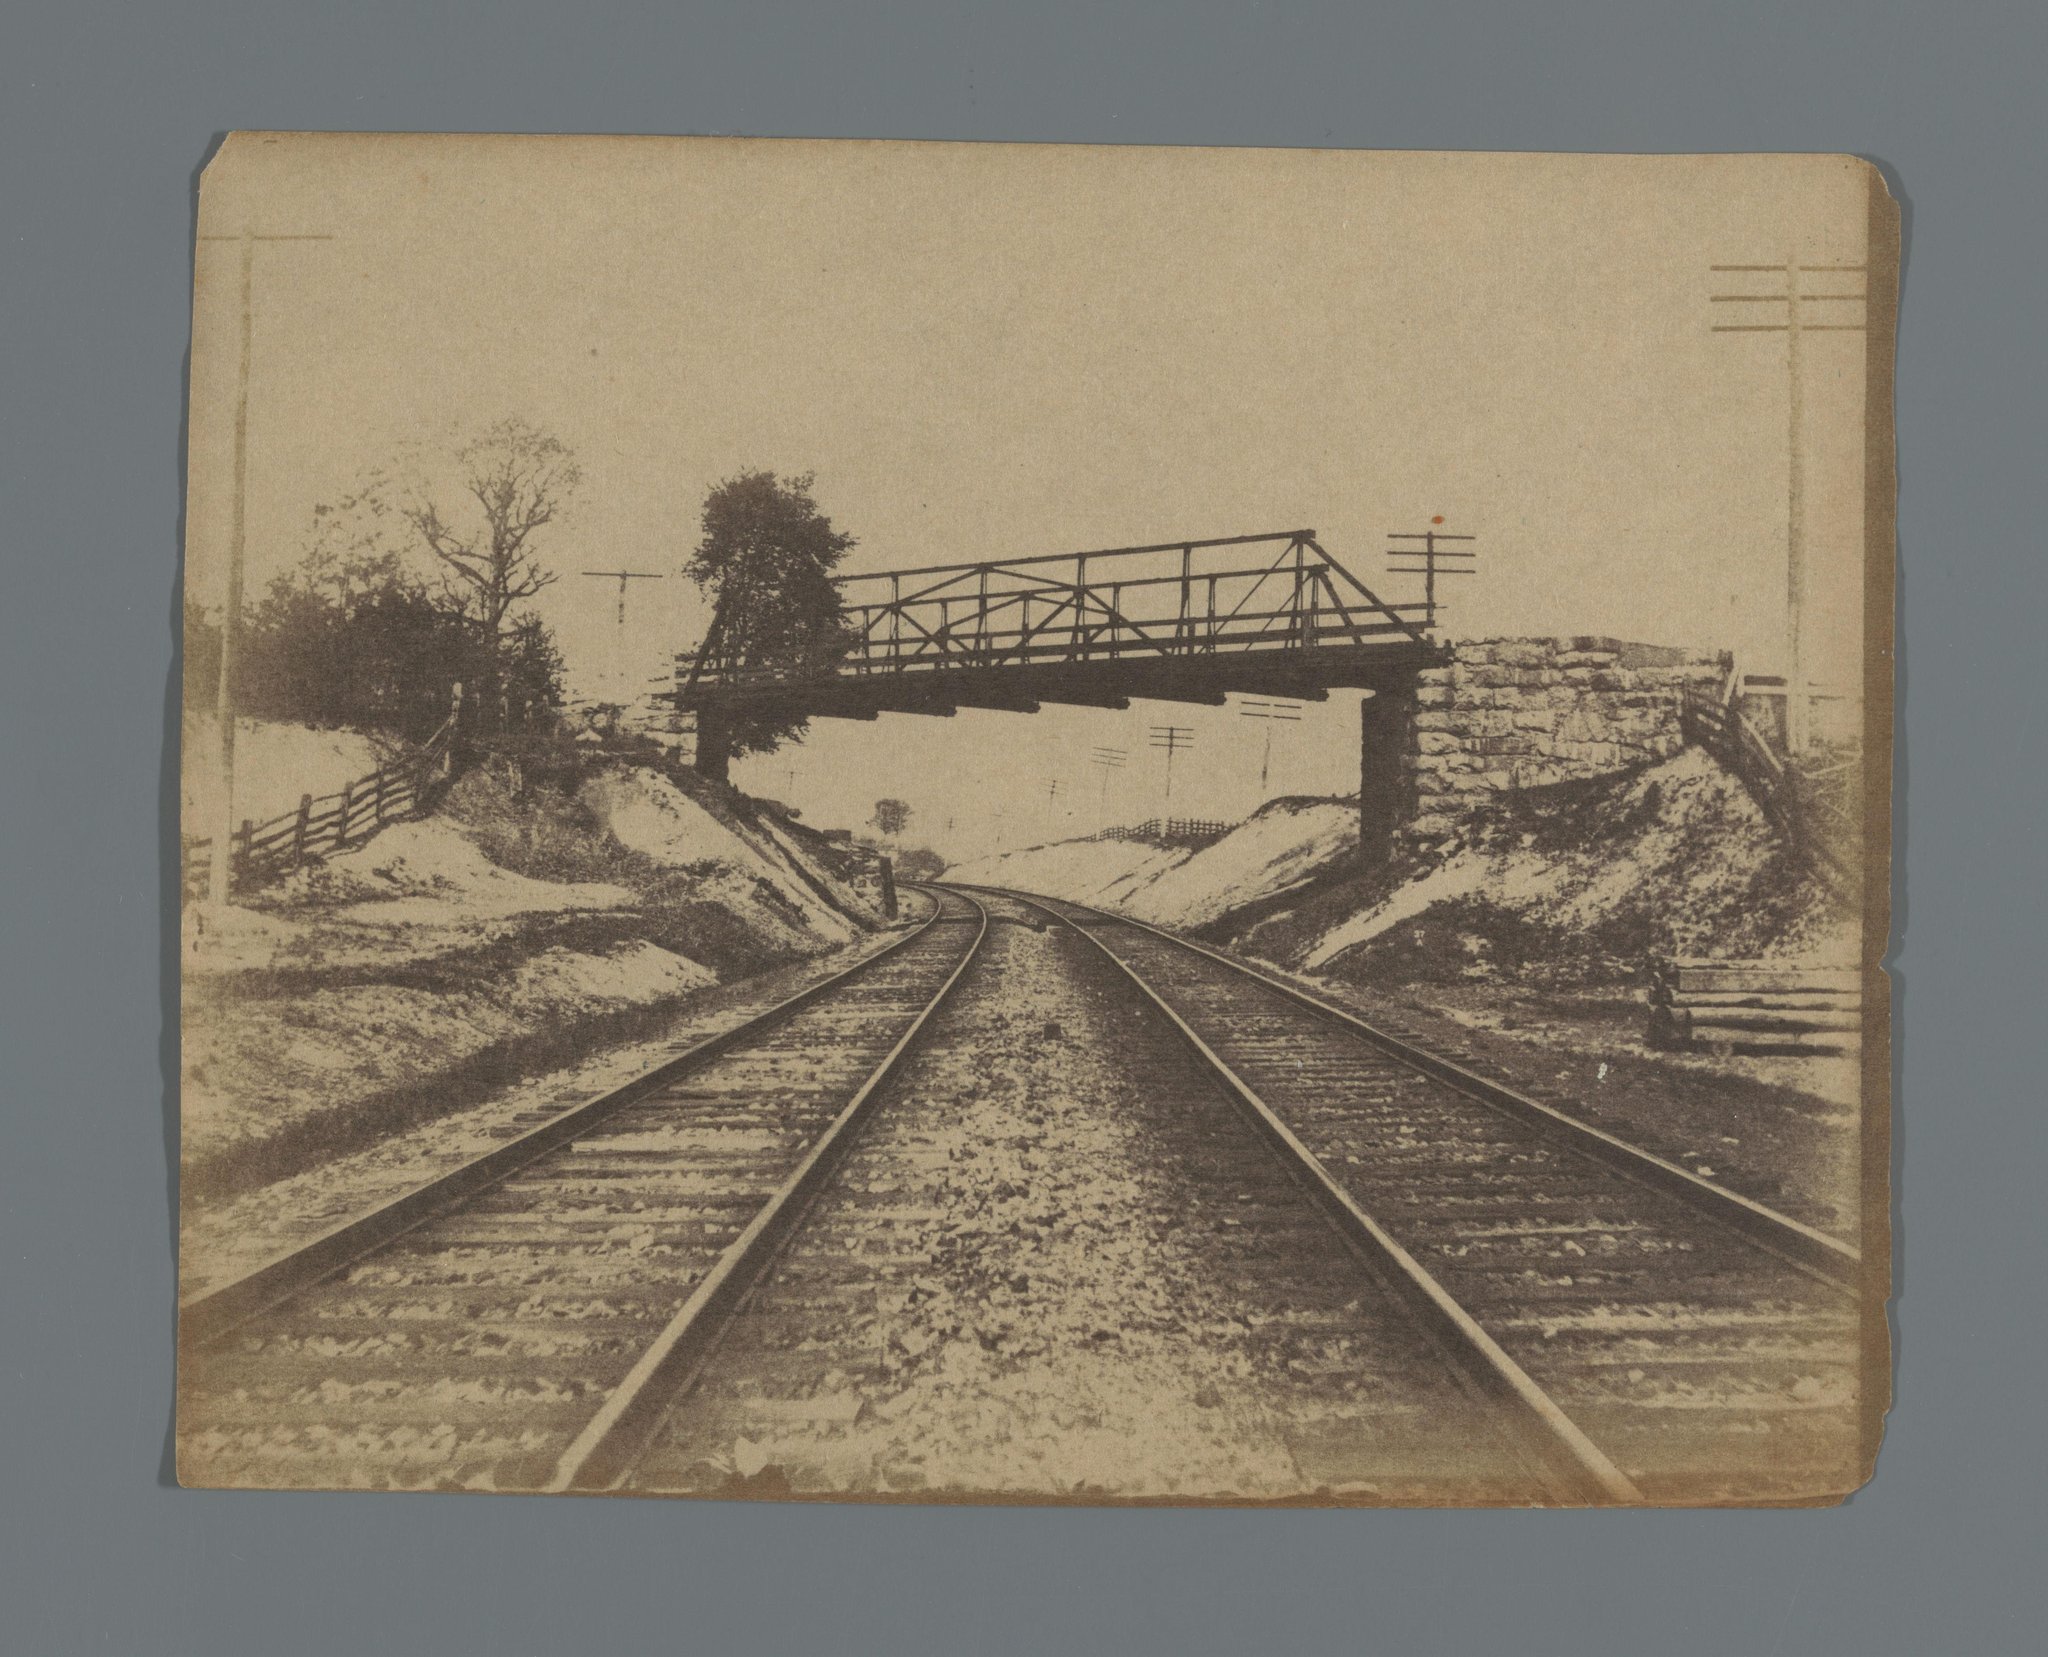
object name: photograph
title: Aanleg spoorbruggen, Verenigde Staten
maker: Anonymous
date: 1900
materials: paper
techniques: salted paper print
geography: united states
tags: railway, tramway; rack railway, bridge, united states of america